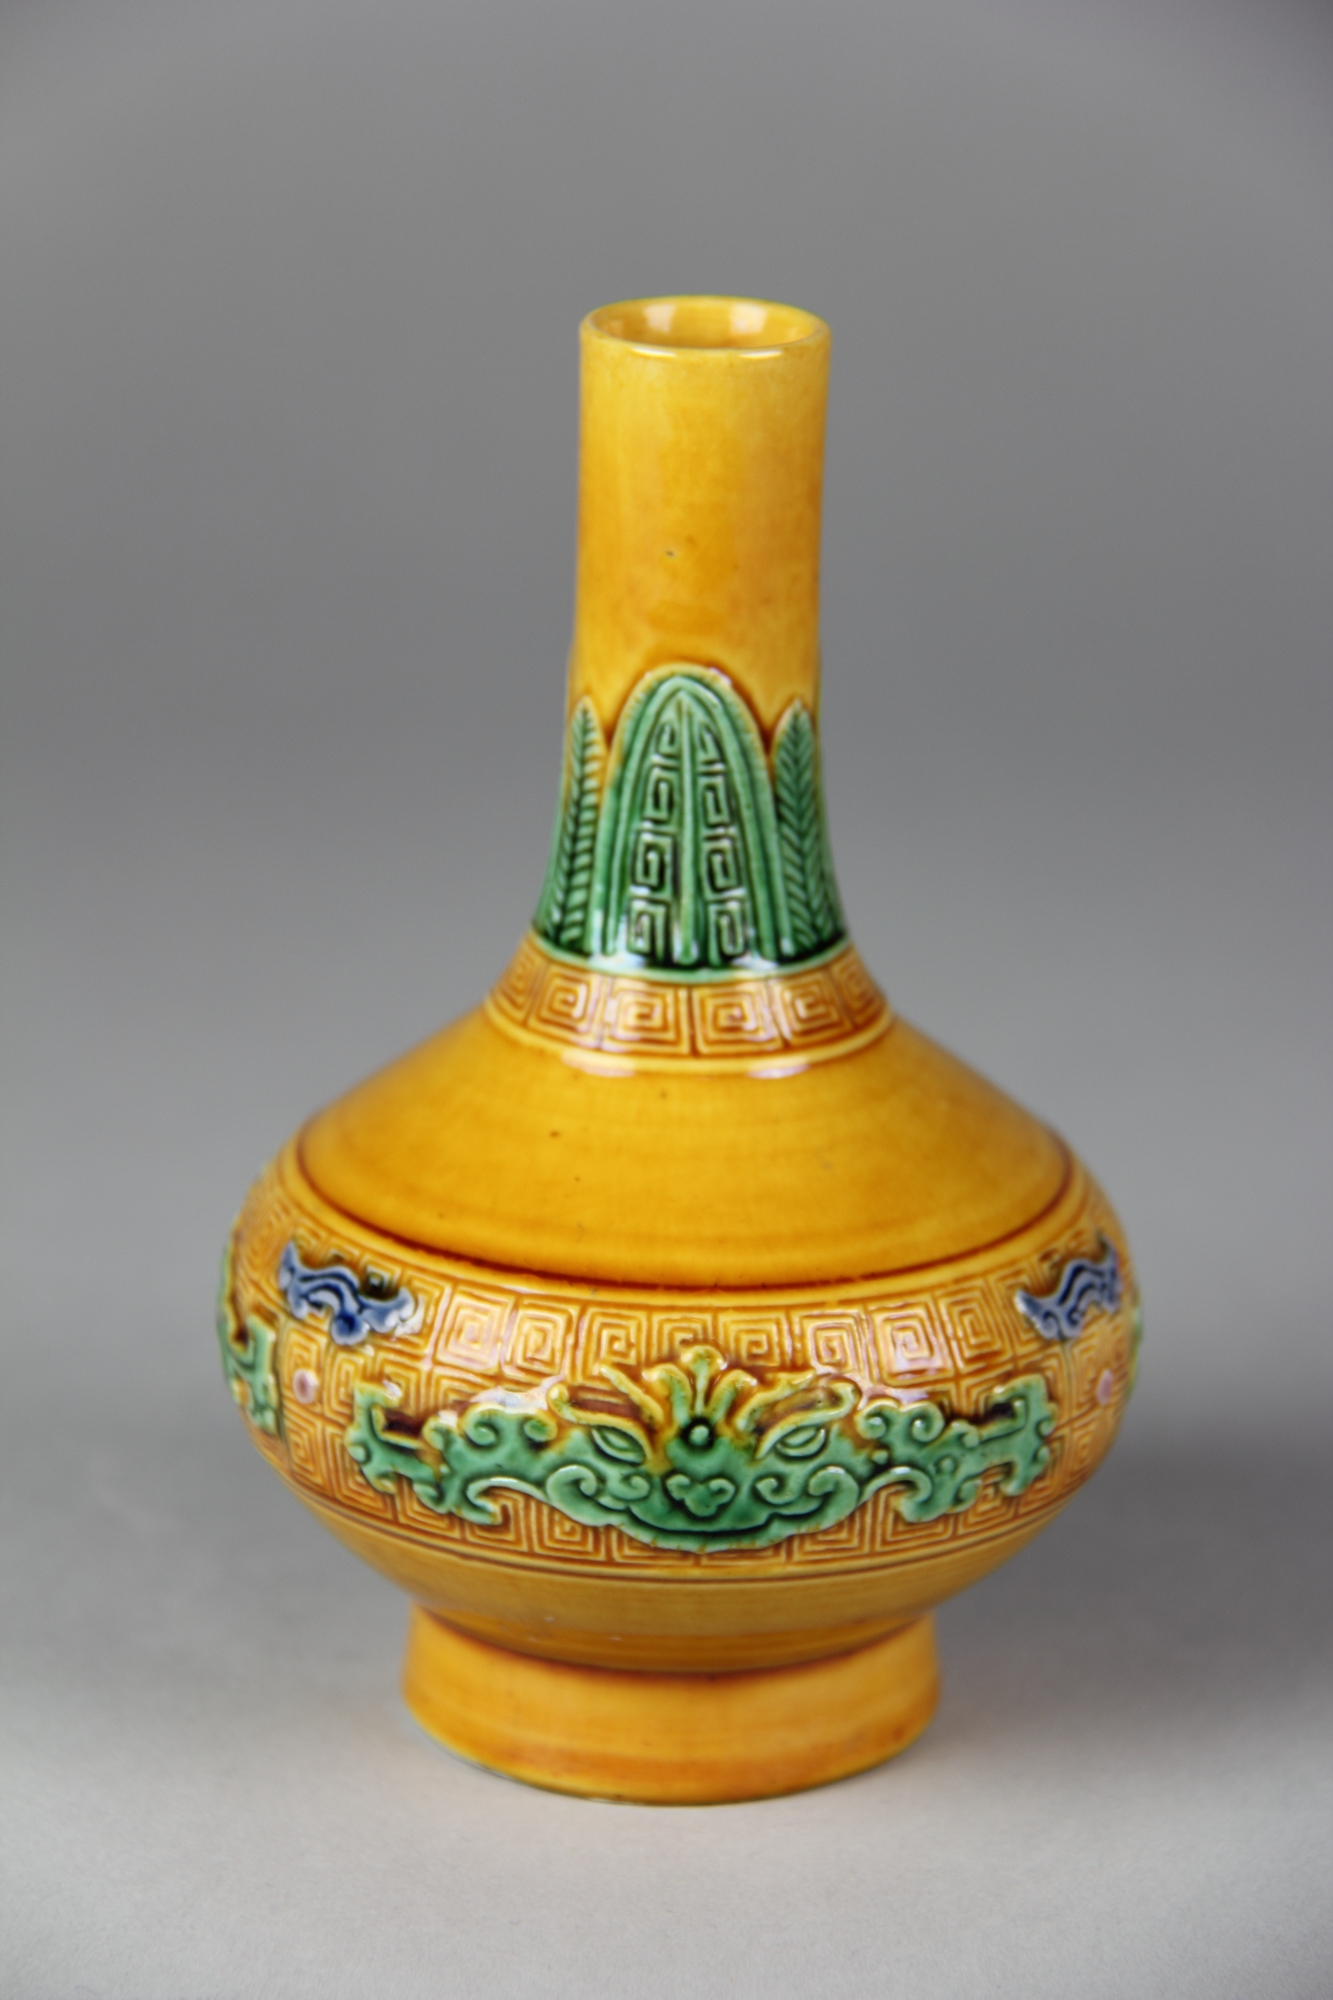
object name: vase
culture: chinese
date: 1796-1820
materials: glaze, porcelain